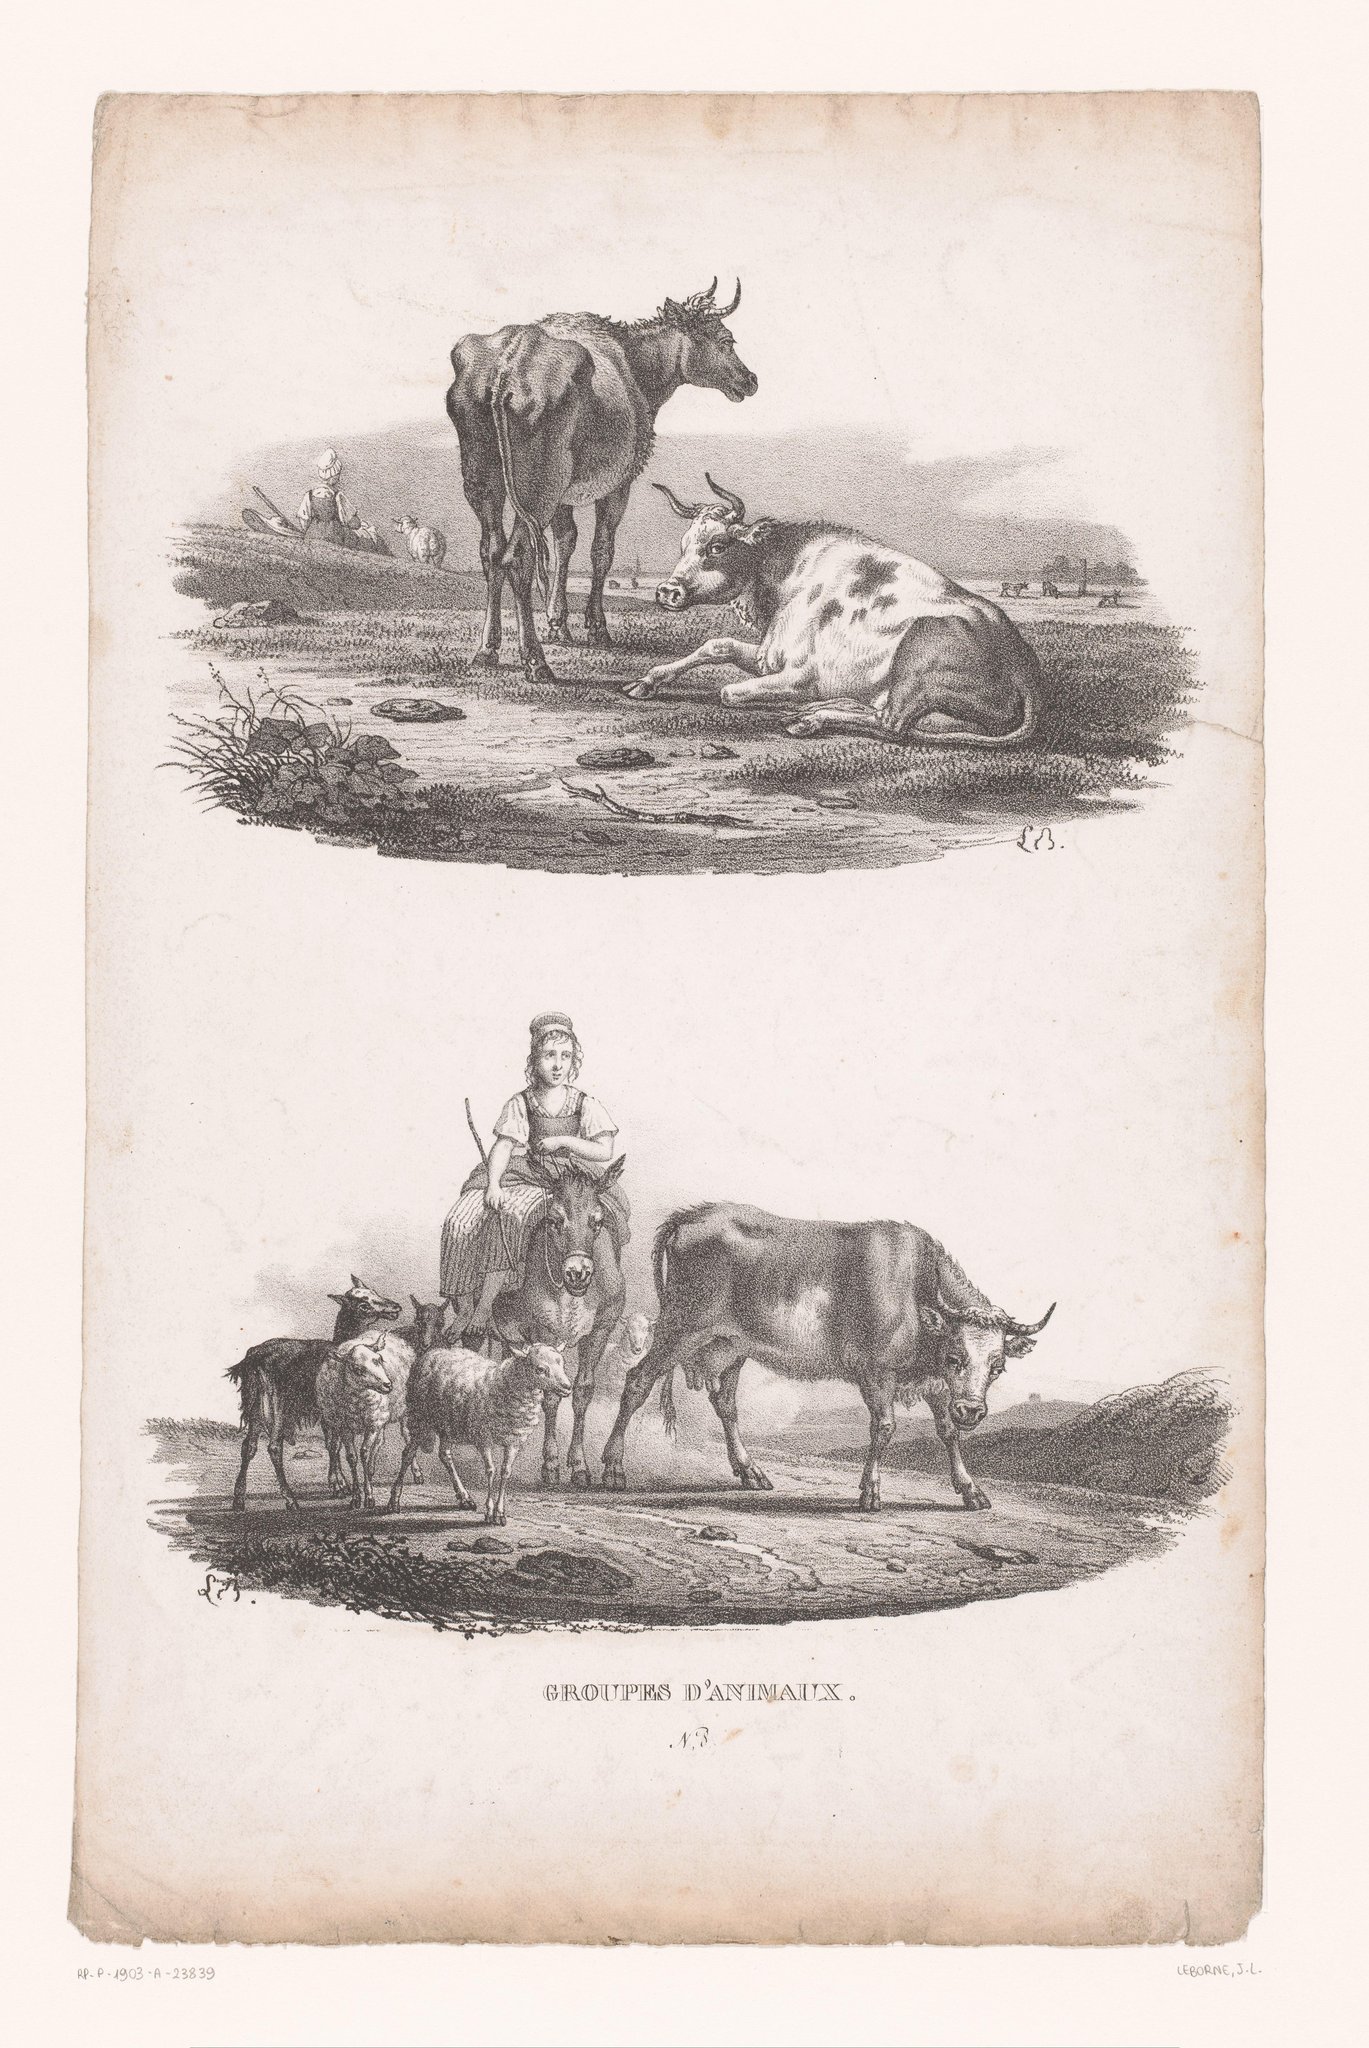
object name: print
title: Groupes d'animaux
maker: joseph louis leborne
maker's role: painter, print maker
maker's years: 1796-1865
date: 1828-1829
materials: paper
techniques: lithograph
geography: paris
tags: cow, herding, herdsman, herdswoman, shepherd, shepherdess, cowherd, etc., cattle driving, cattle driver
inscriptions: collector's mark: Lugt 2228a